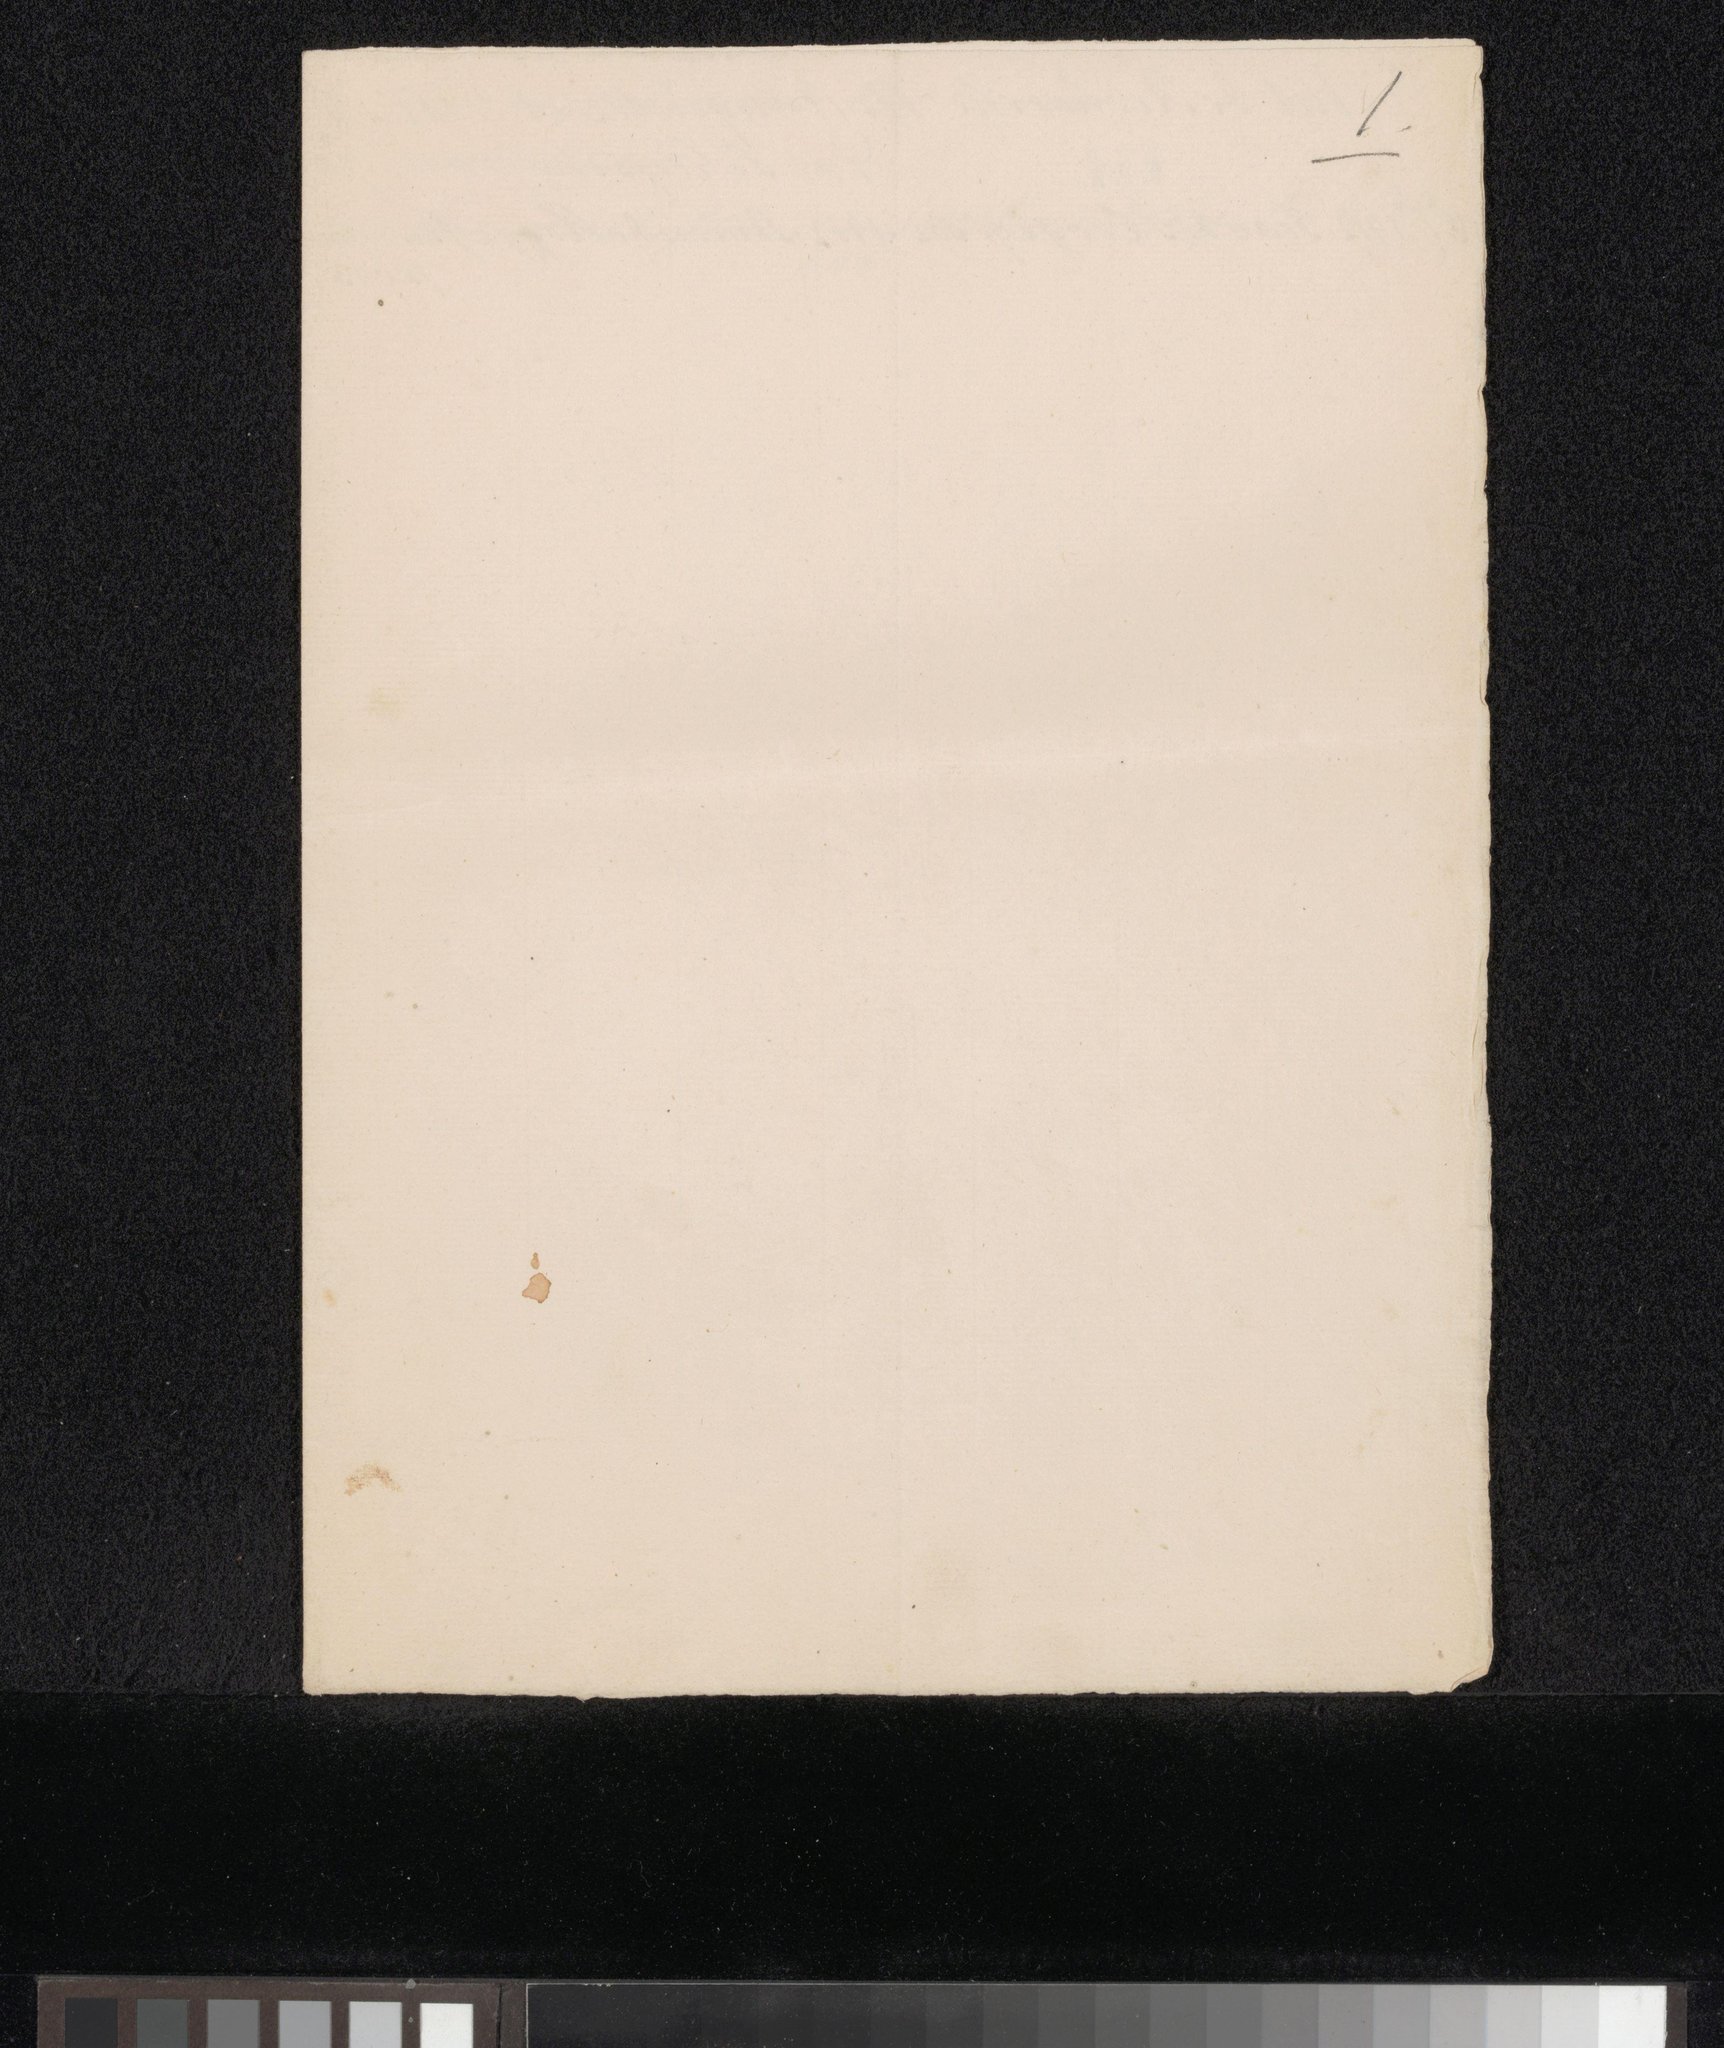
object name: manuscript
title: Handschrift betreffende de familie De Hooghe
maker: Anonymous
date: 1708-1799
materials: ink, paper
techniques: pen, writing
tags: amsterdam, haarlem, print maker, draughtsman, goldsmith, romeyn de hooghe, ghent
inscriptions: collector's mark: Lugt 2233, watermark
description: Overzicht van leden van de familie De Hooghe die schepen in Gent zijn geweest.